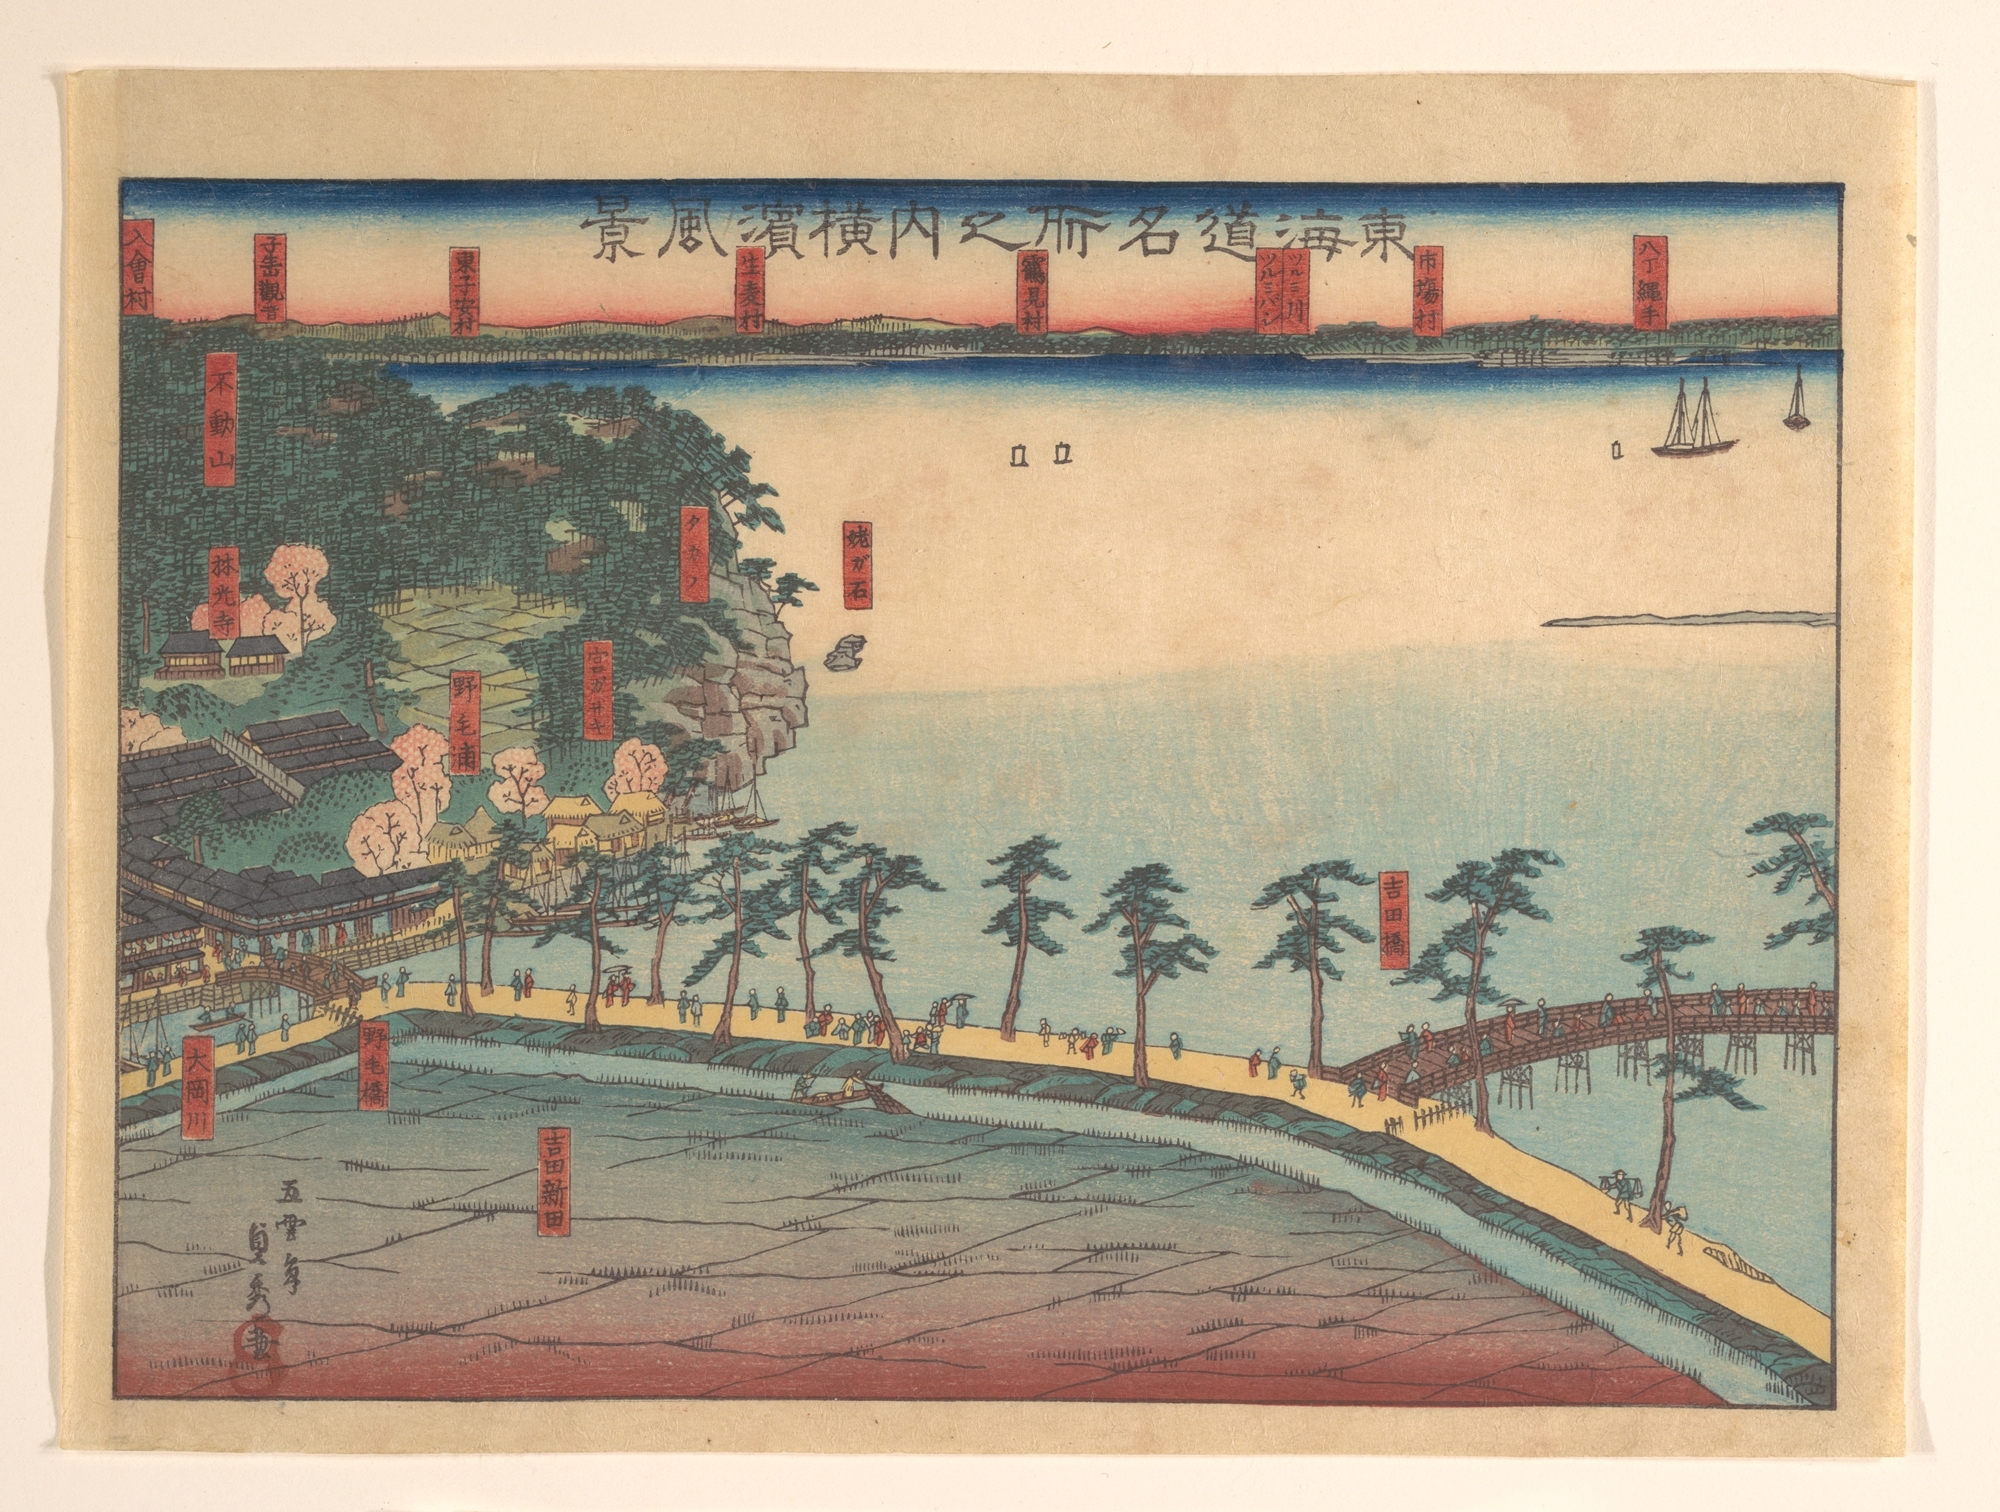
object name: print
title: Landscape View at Yokohama (Yokohama fūkei)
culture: japanese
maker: utagawa (gountei) sadahide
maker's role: artist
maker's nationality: japanese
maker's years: 1807-1873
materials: ink, paper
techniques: woodblock print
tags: bridges,landscapes,trees